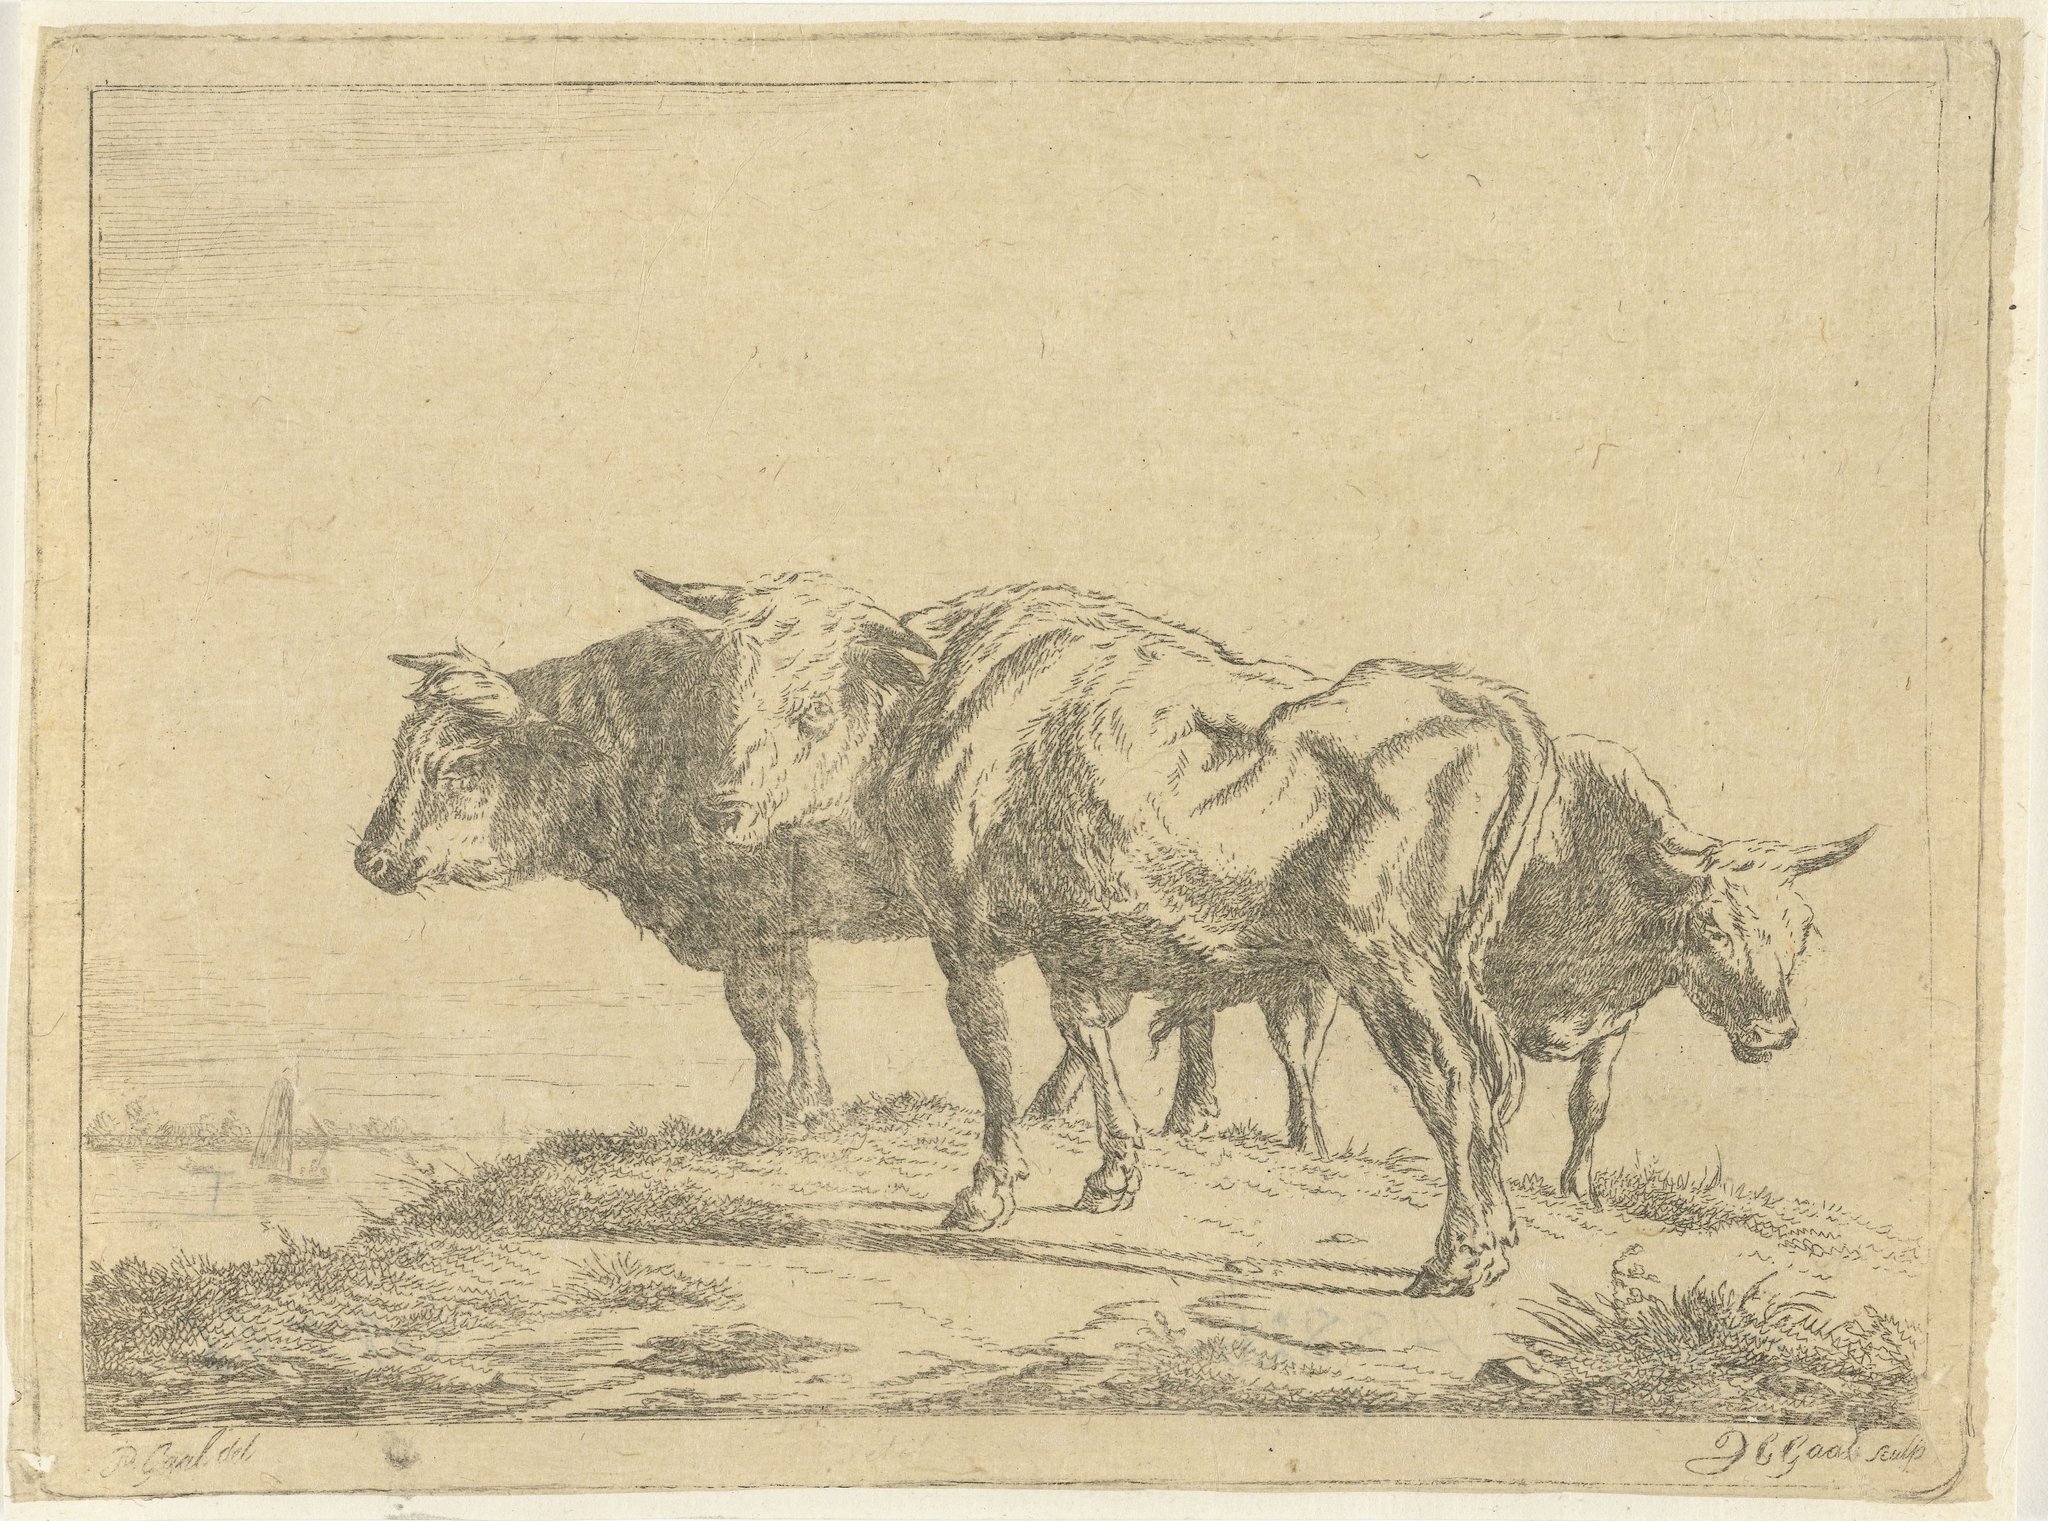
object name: print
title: Drie ossen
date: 1854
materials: paper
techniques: etching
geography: netherlands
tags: bull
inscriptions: collector's mark: Lugt 2228